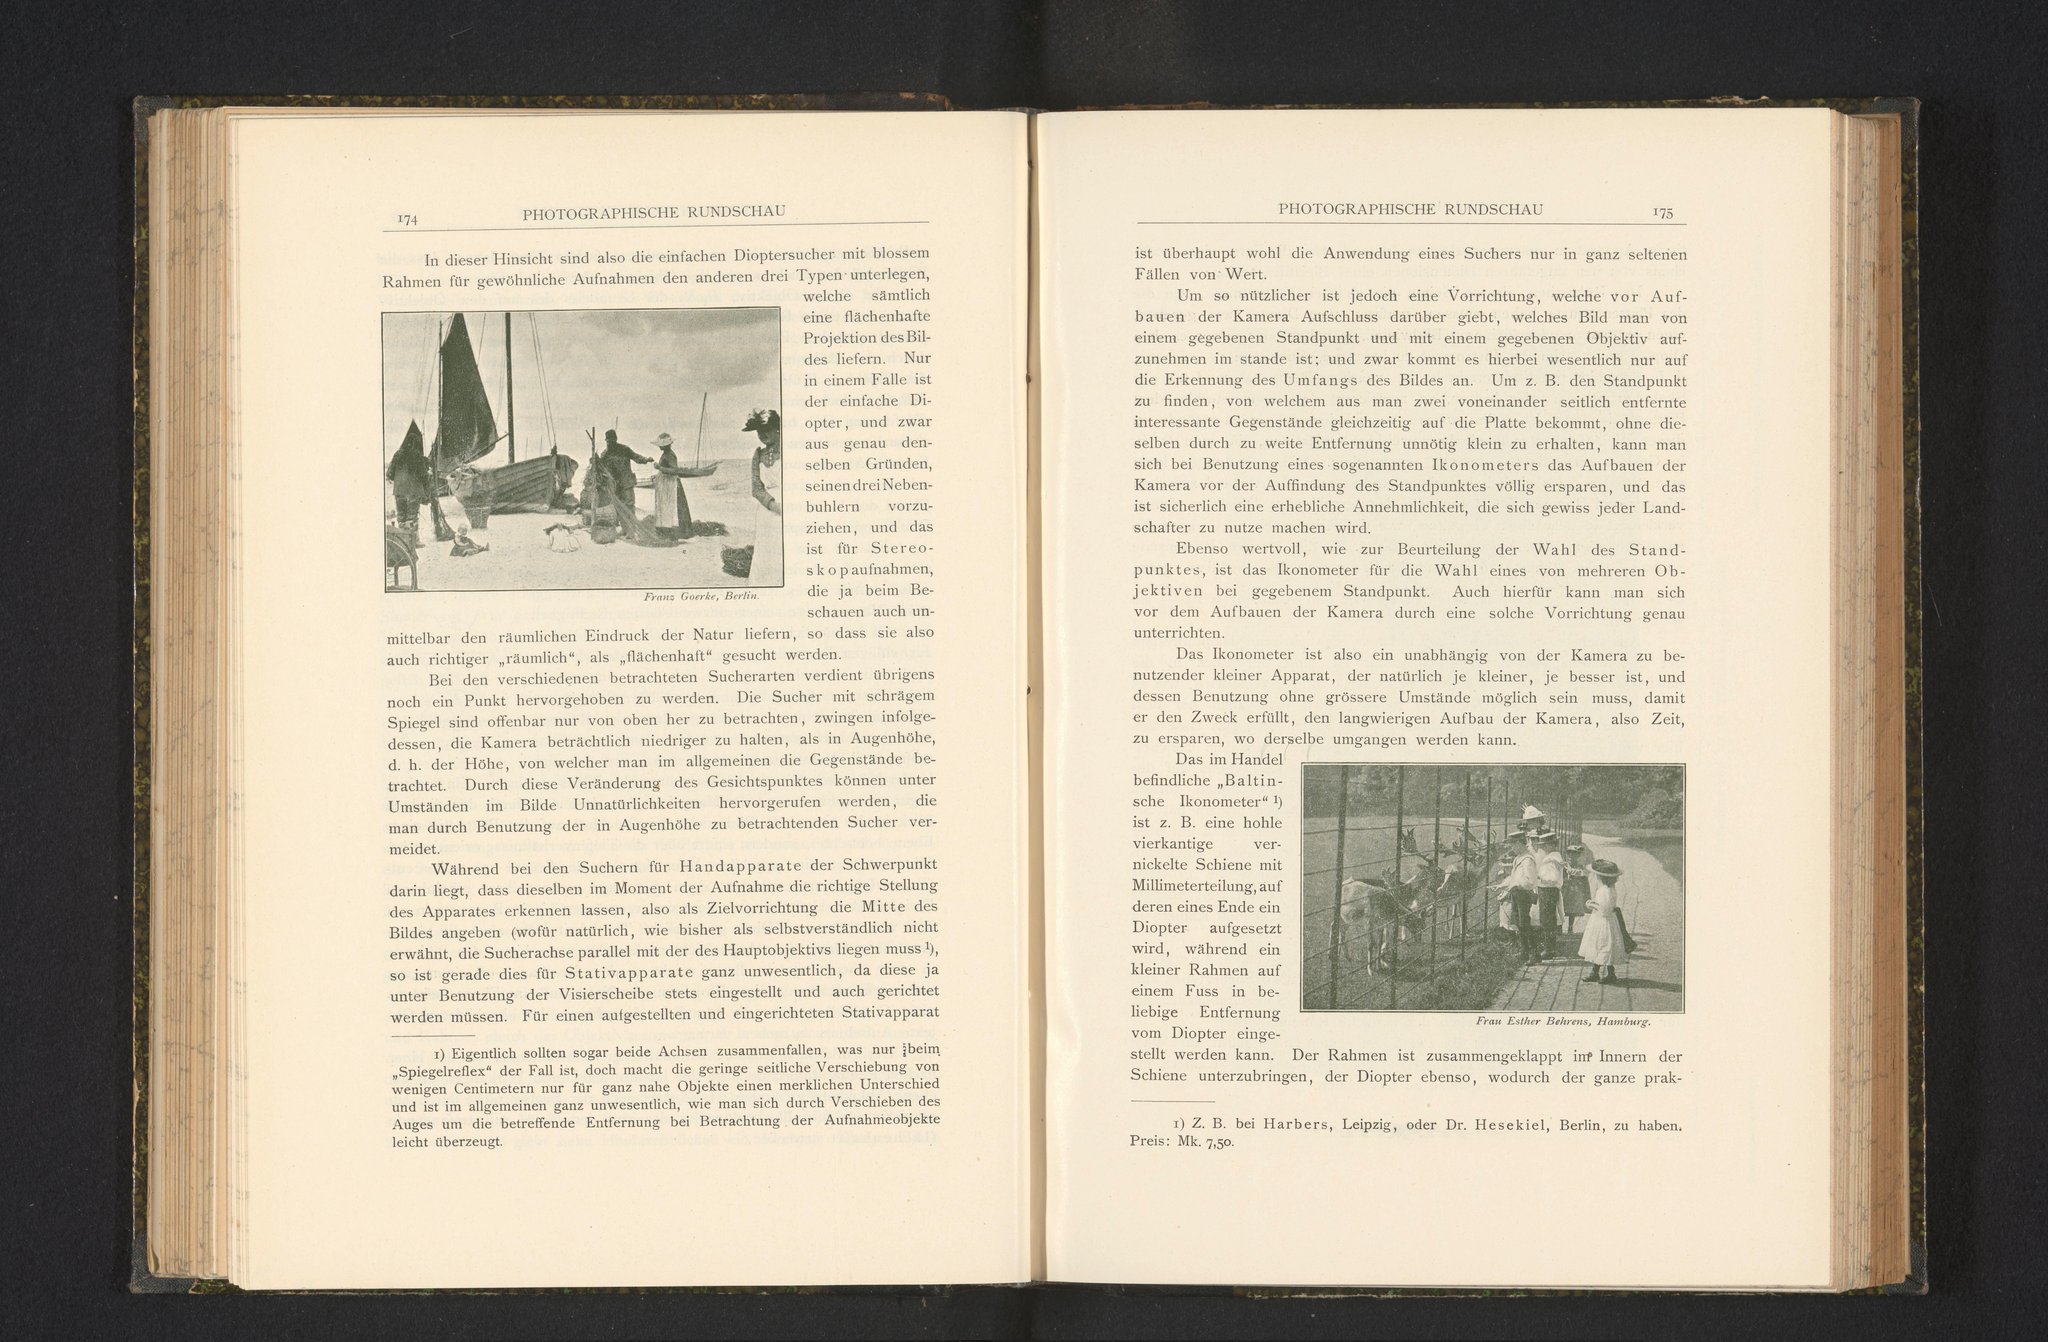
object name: page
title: Vissers naast schepen op het strand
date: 1893-1898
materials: paper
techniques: autotype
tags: beach, fisherman, ships, boats on land, beached